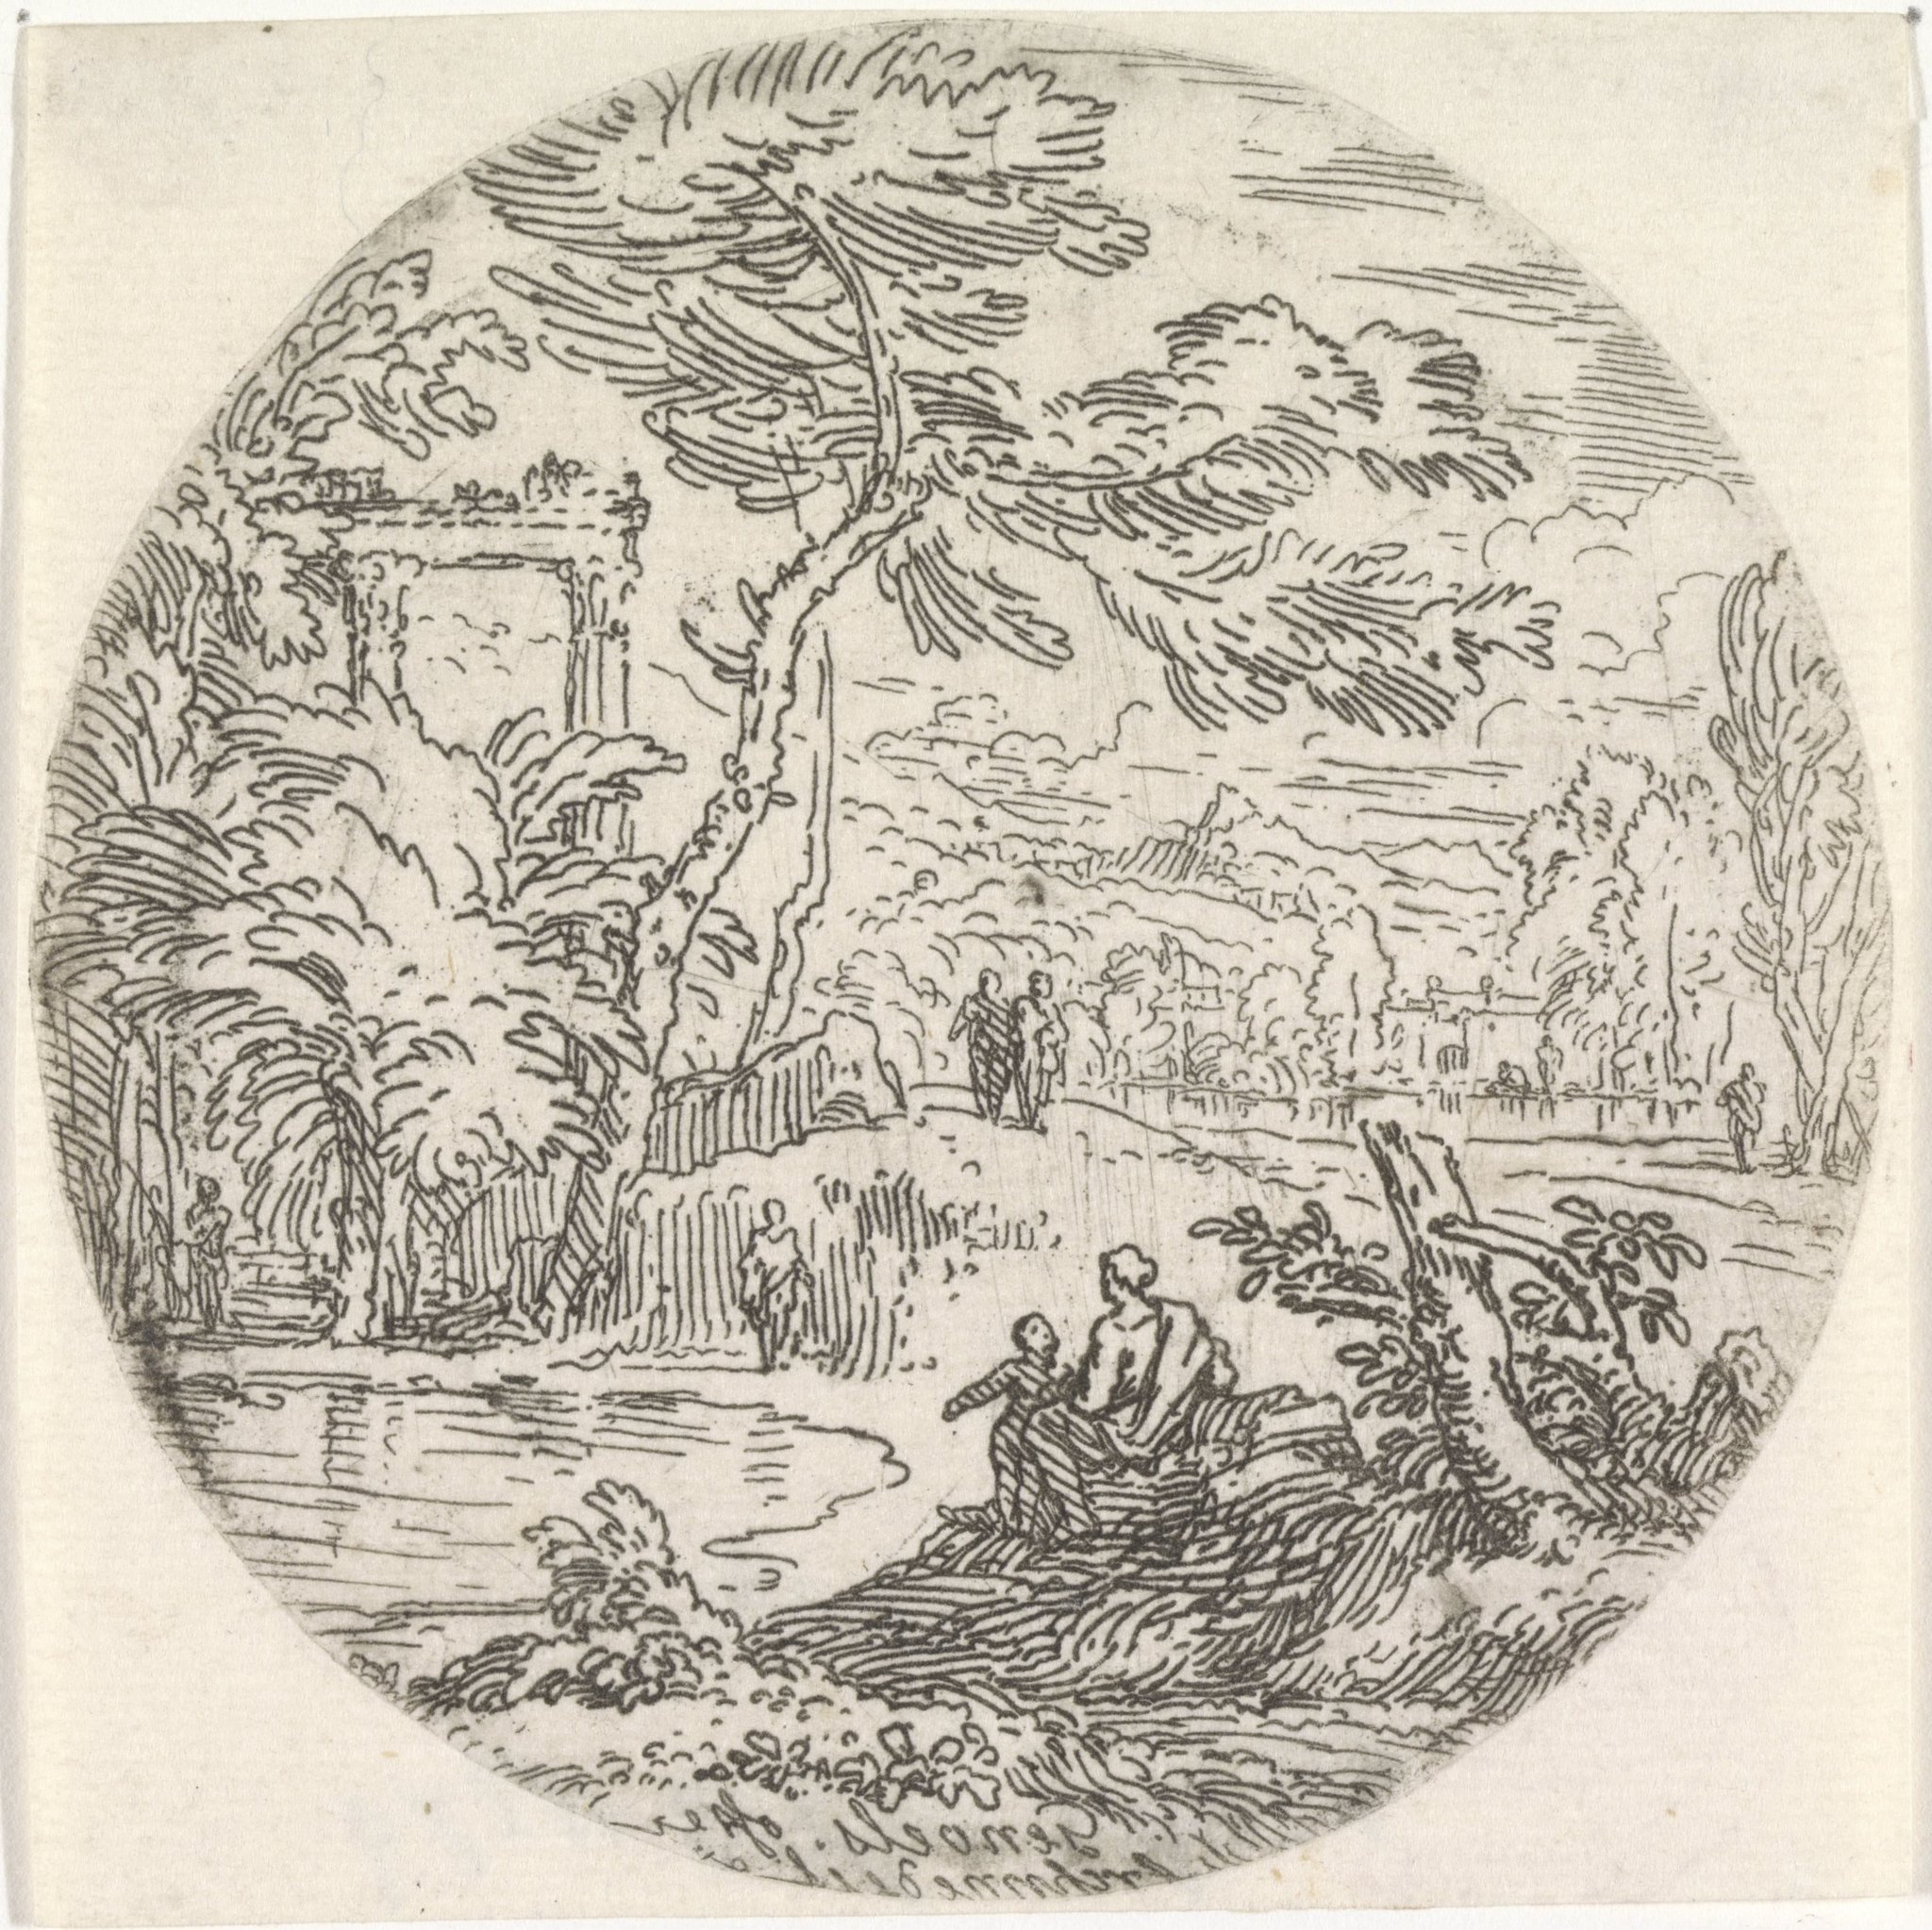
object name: print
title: Landschap met vijver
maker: abraham genoels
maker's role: draughtsman, print maker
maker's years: 1640-1723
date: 1650-1723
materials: paper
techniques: etching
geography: paris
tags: temple, shrine ~ roman religion, mother and baby or young child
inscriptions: collector's mark: Lugt 240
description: Landschap met een vijver links. Rechts een weg. Op de achtergrond een tempel